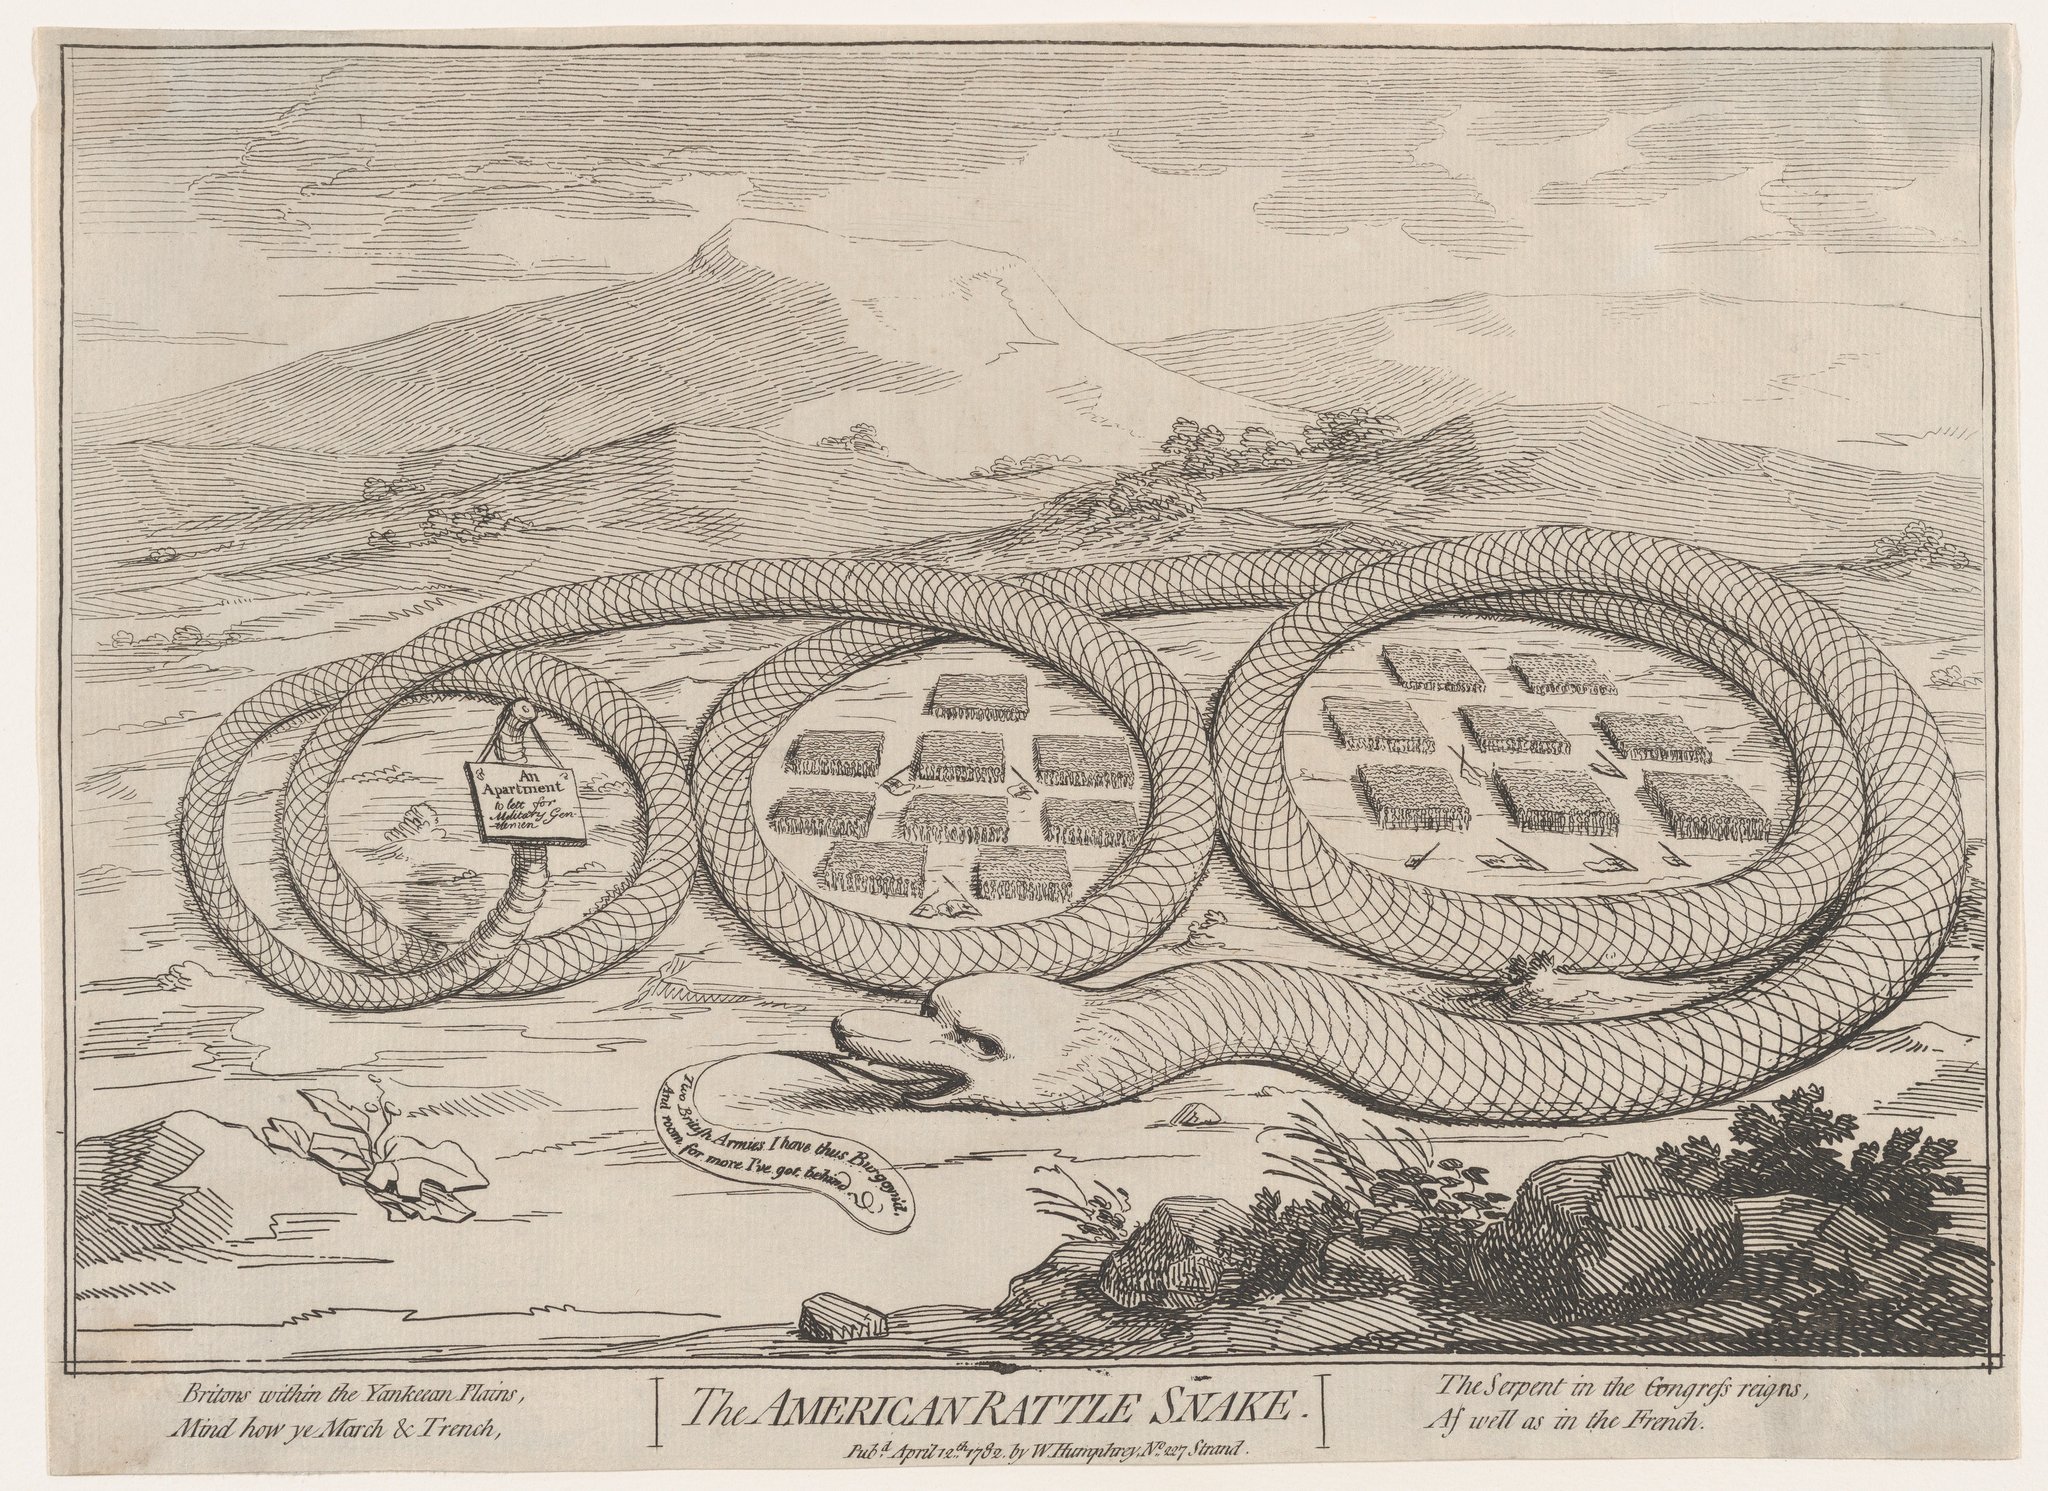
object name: print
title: The American Rattle Snake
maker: james gillray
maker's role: artist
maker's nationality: british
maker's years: 1756-1815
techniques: etching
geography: london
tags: satire,american revolution,snakes